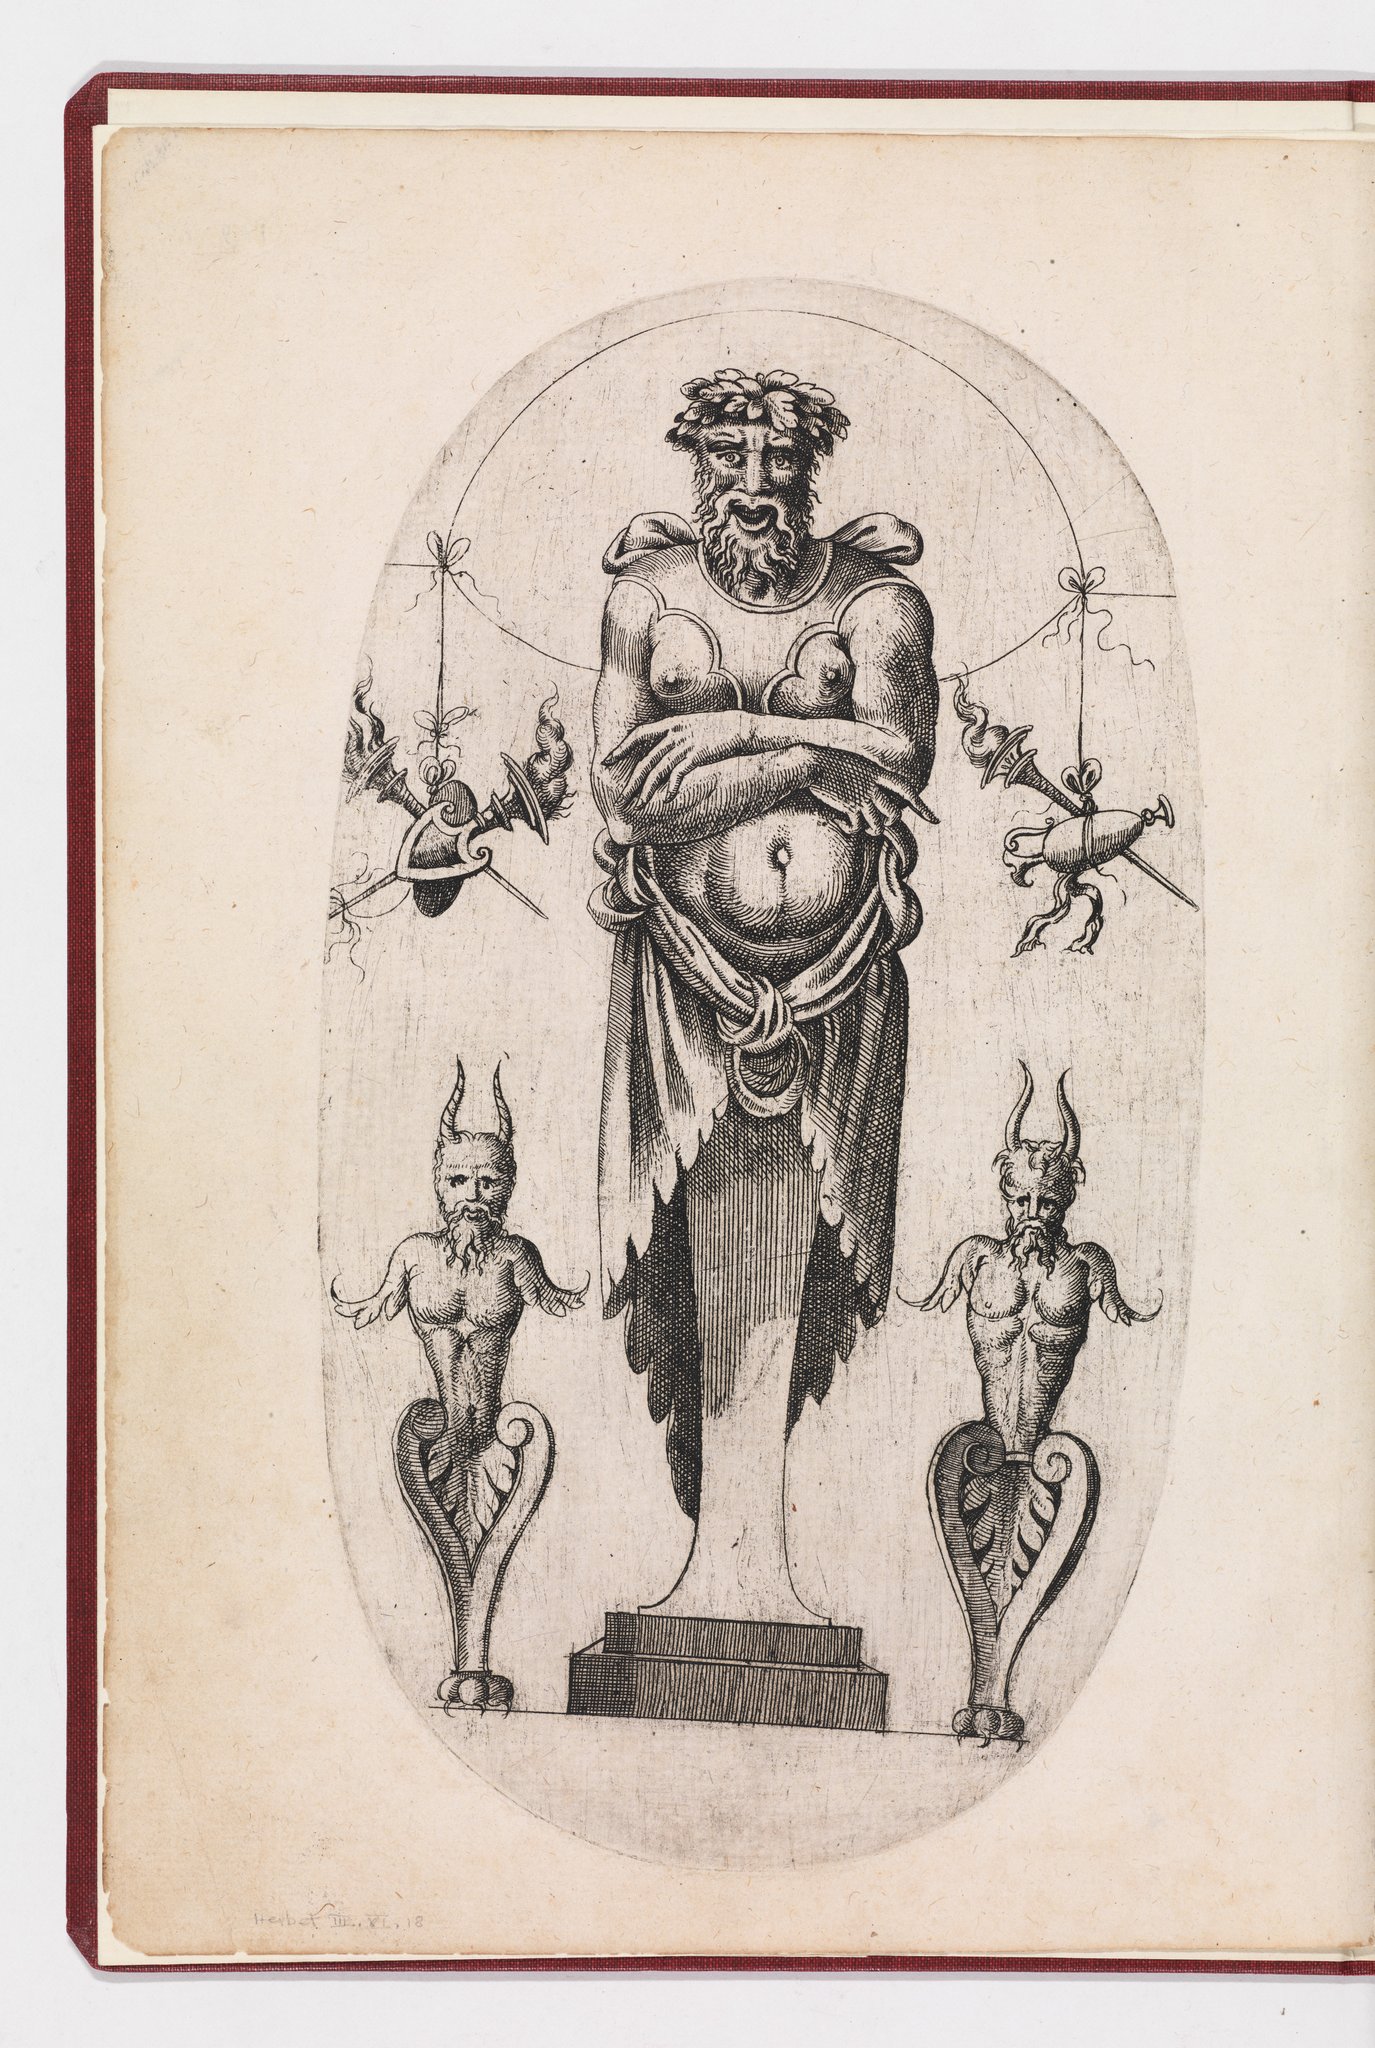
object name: album print ornament architecture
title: Designs for Terms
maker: jean mignon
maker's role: artist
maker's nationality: french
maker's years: 1535-1555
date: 1543-1545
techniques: etching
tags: shields,trophies